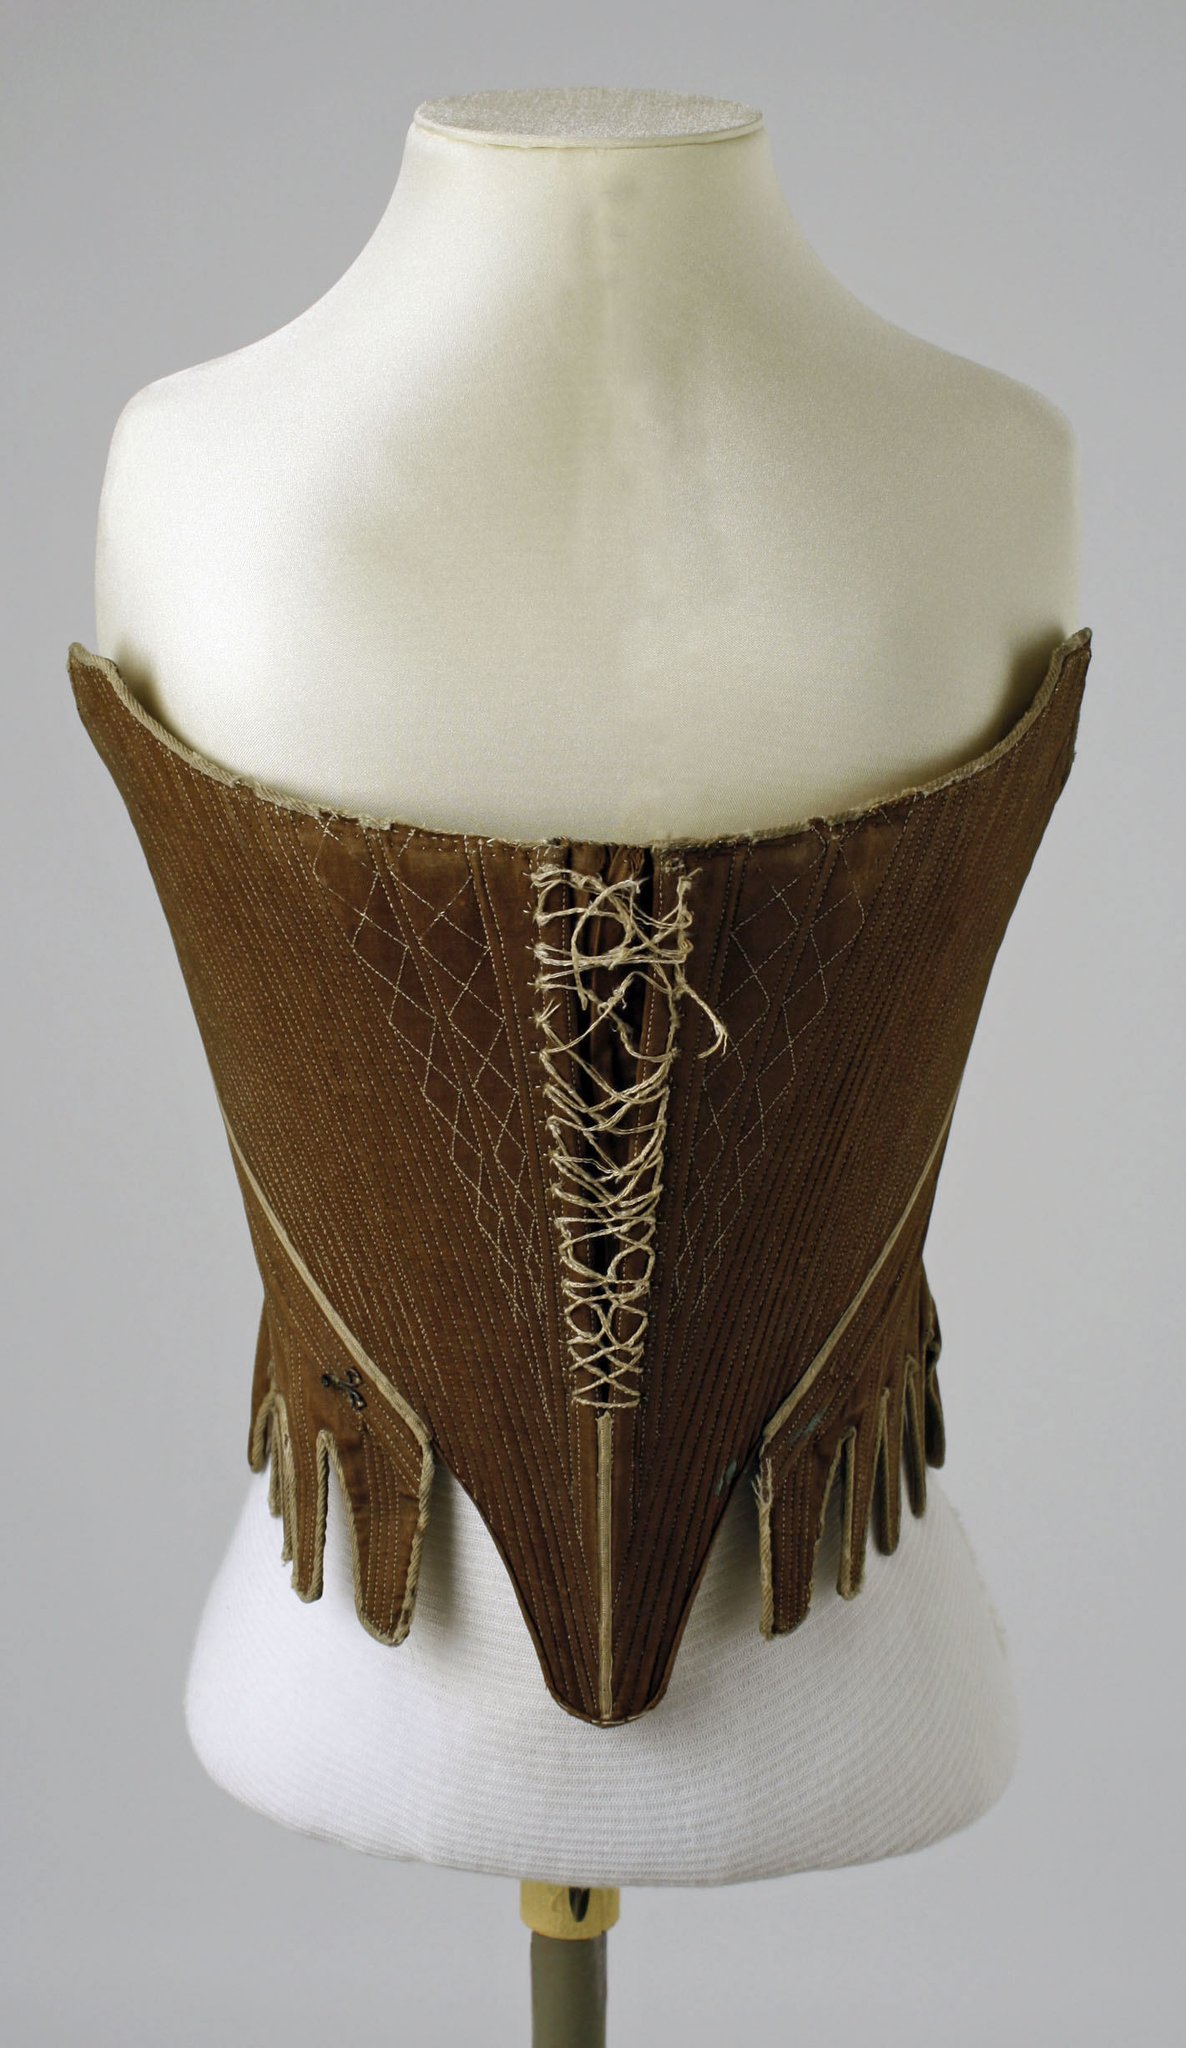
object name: corset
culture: british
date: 1780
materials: cotton, metal, wood